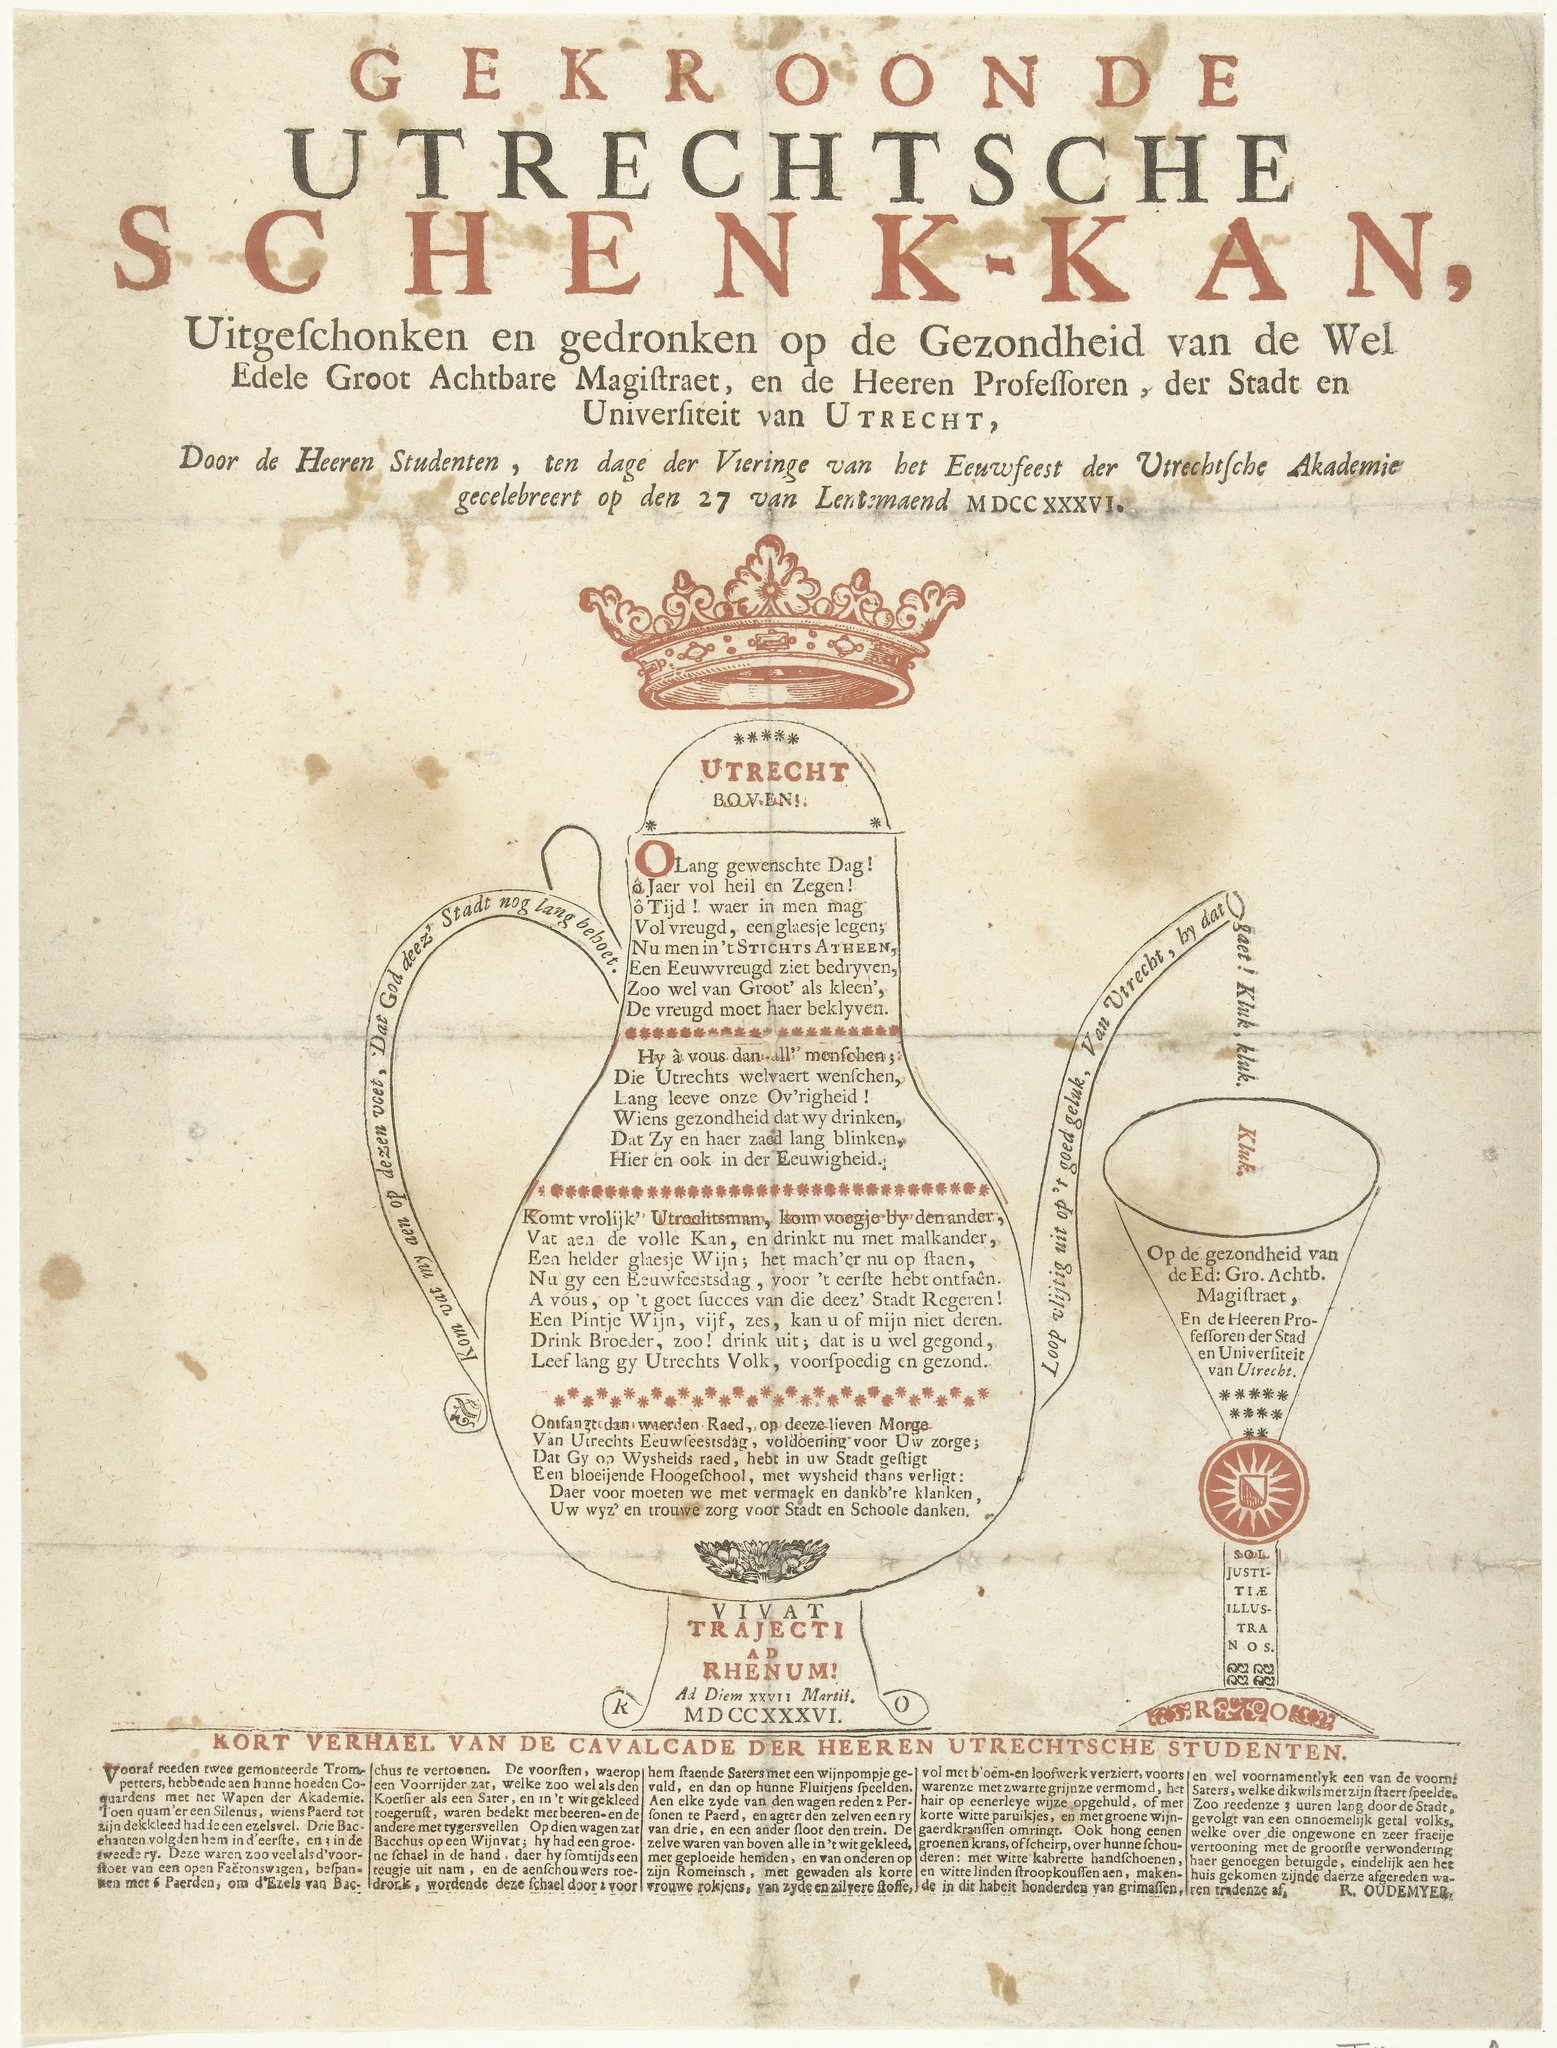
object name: print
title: De gekroonde Utrechtse schenkkan, 1736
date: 1736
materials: paper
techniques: letterpress printing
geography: utrecht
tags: container of ceramics: jar, jug, pot, vase, utrecht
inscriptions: collector's mark: Lugt 2228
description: De gekroonde Utrechtse schenkkan. Uit een gekroonde schenkkan wordt wijn in een glas geschonken, beide met opschriften en verzen in boekdruk. In de voet van de kan de datum 1736. Ter gelegenheid van het eeuwfeest van de Universiteit van Utrecht op 27 maart 1736. Met onderschrift in vijf kolommen waarin een beschrjving van de cavalcade door de Utrechtse studenten.